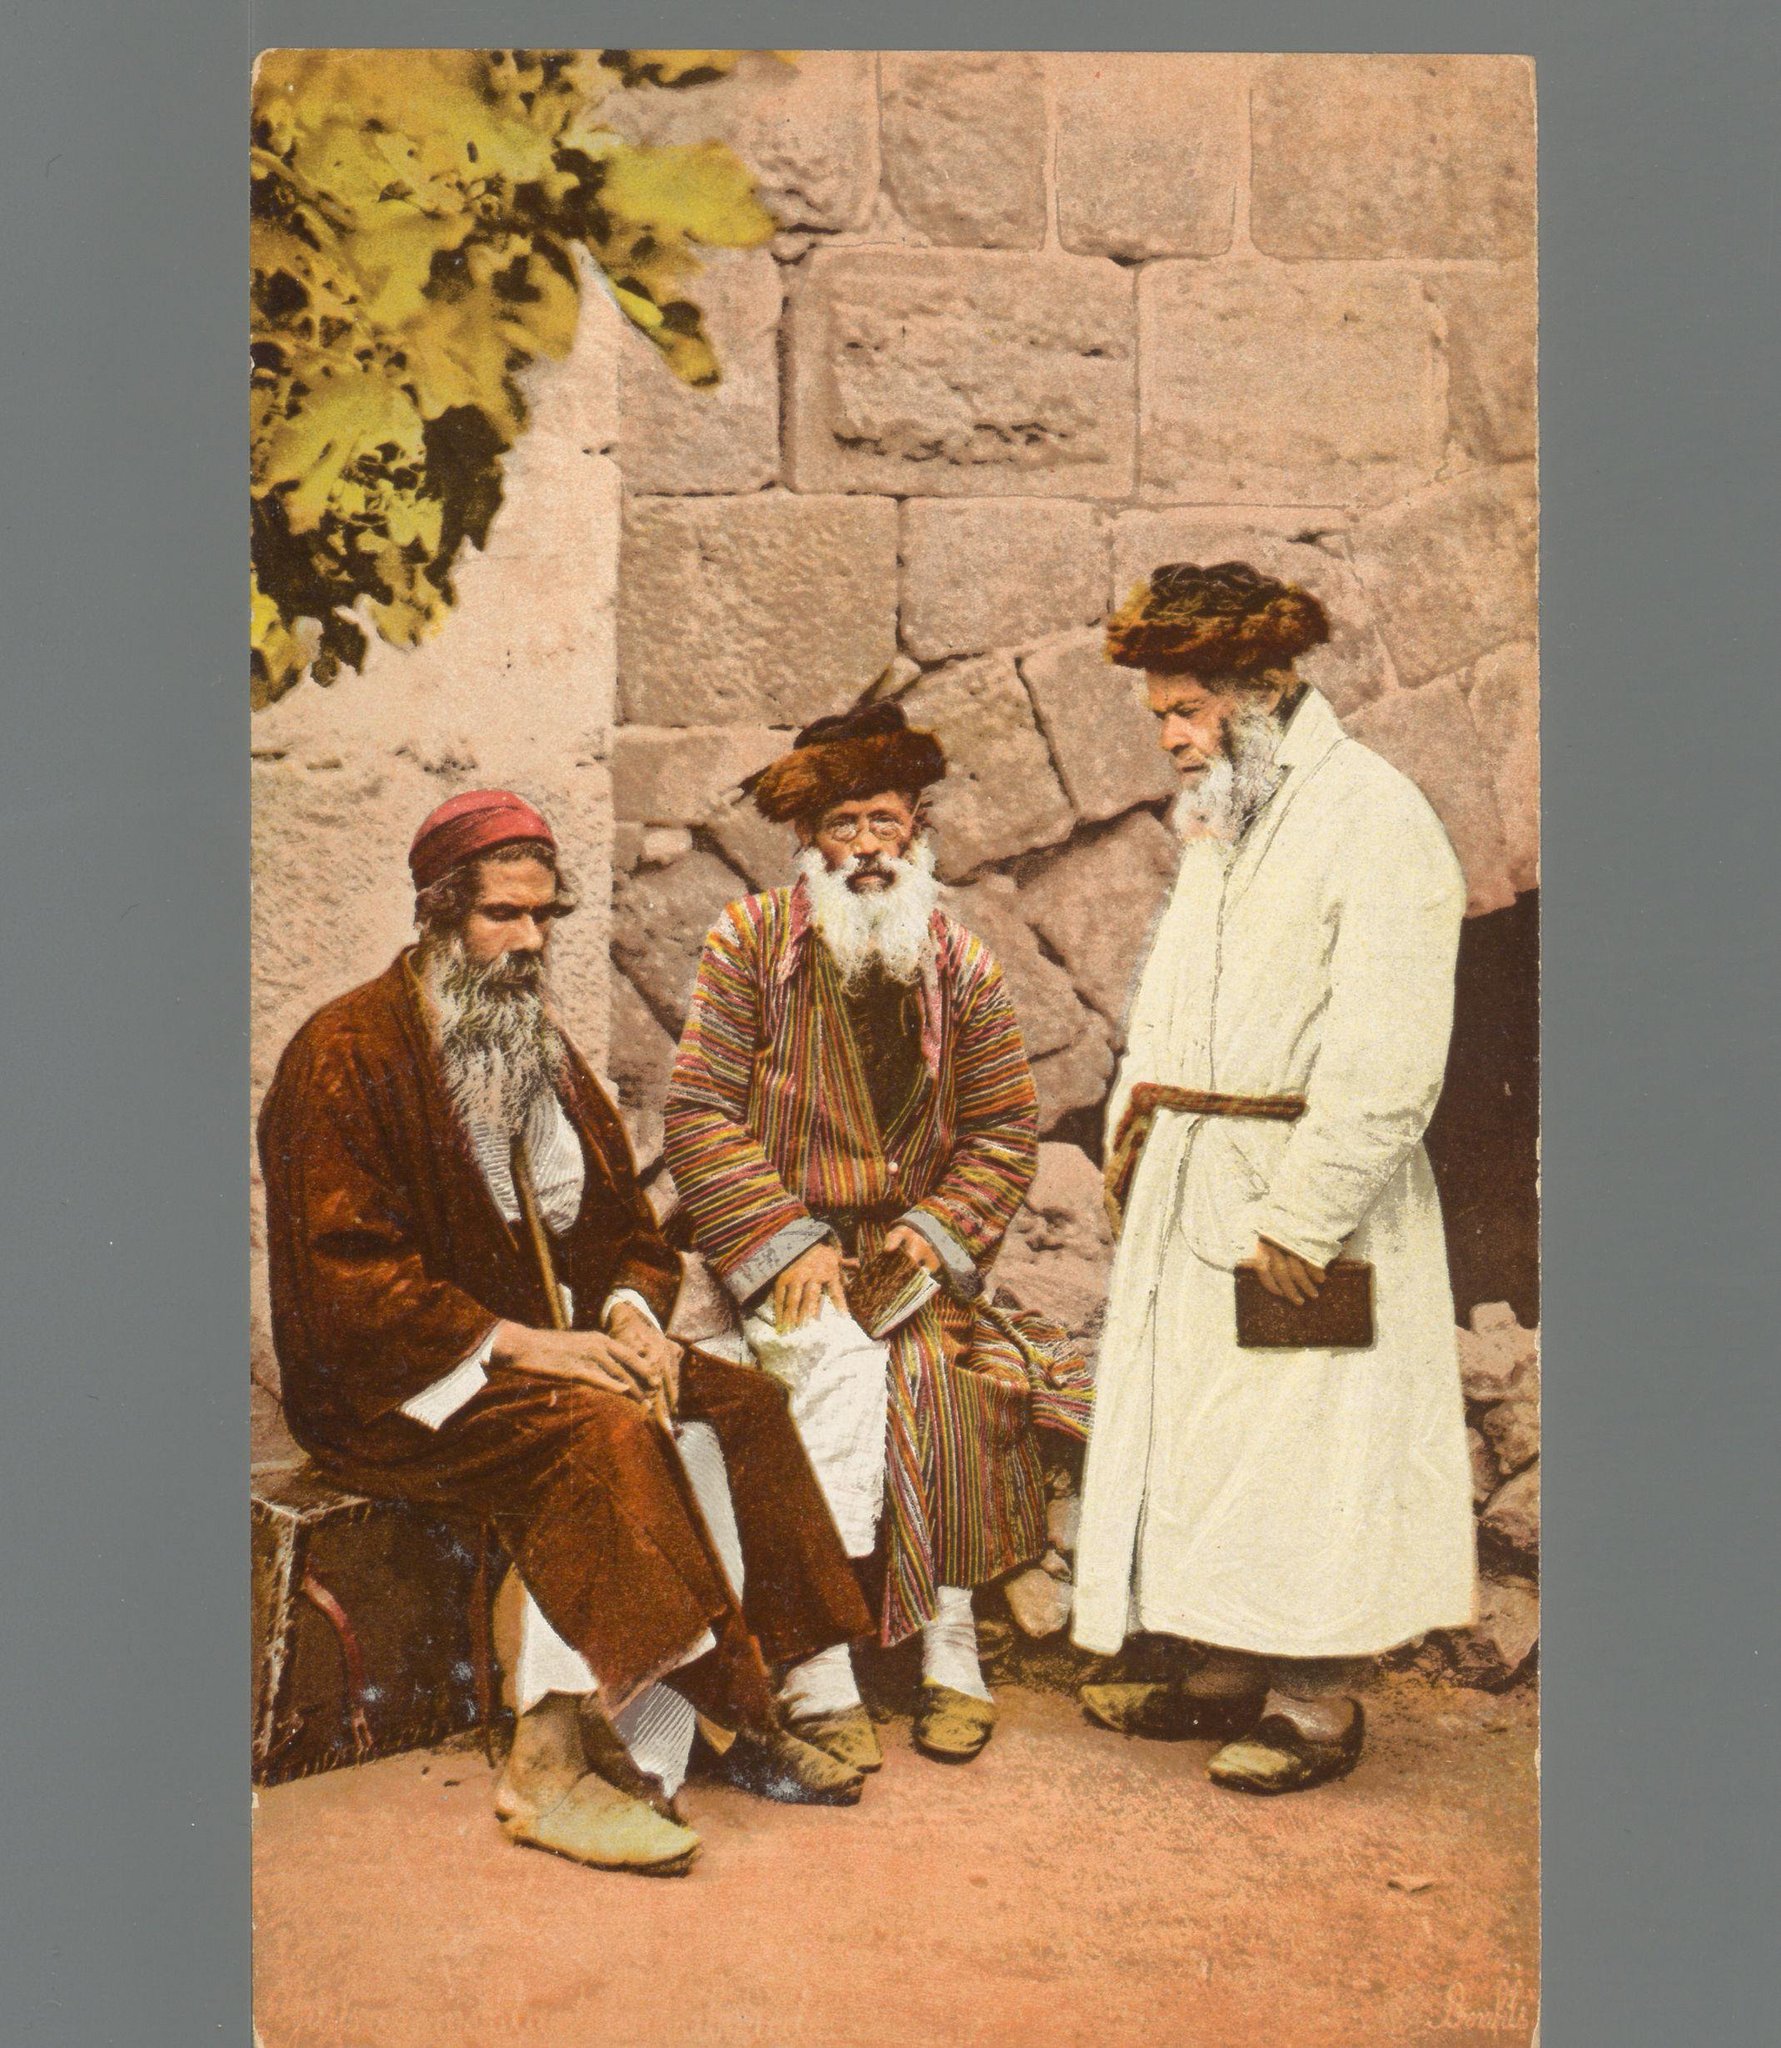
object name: ansichtkaart, prentbriefkaart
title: Juifs de Jérusalem / Jews of Jerusalem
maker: Anonymous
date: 1905-1930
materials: cardboard, photographic process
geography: jerusalem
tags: the jews, jewish life